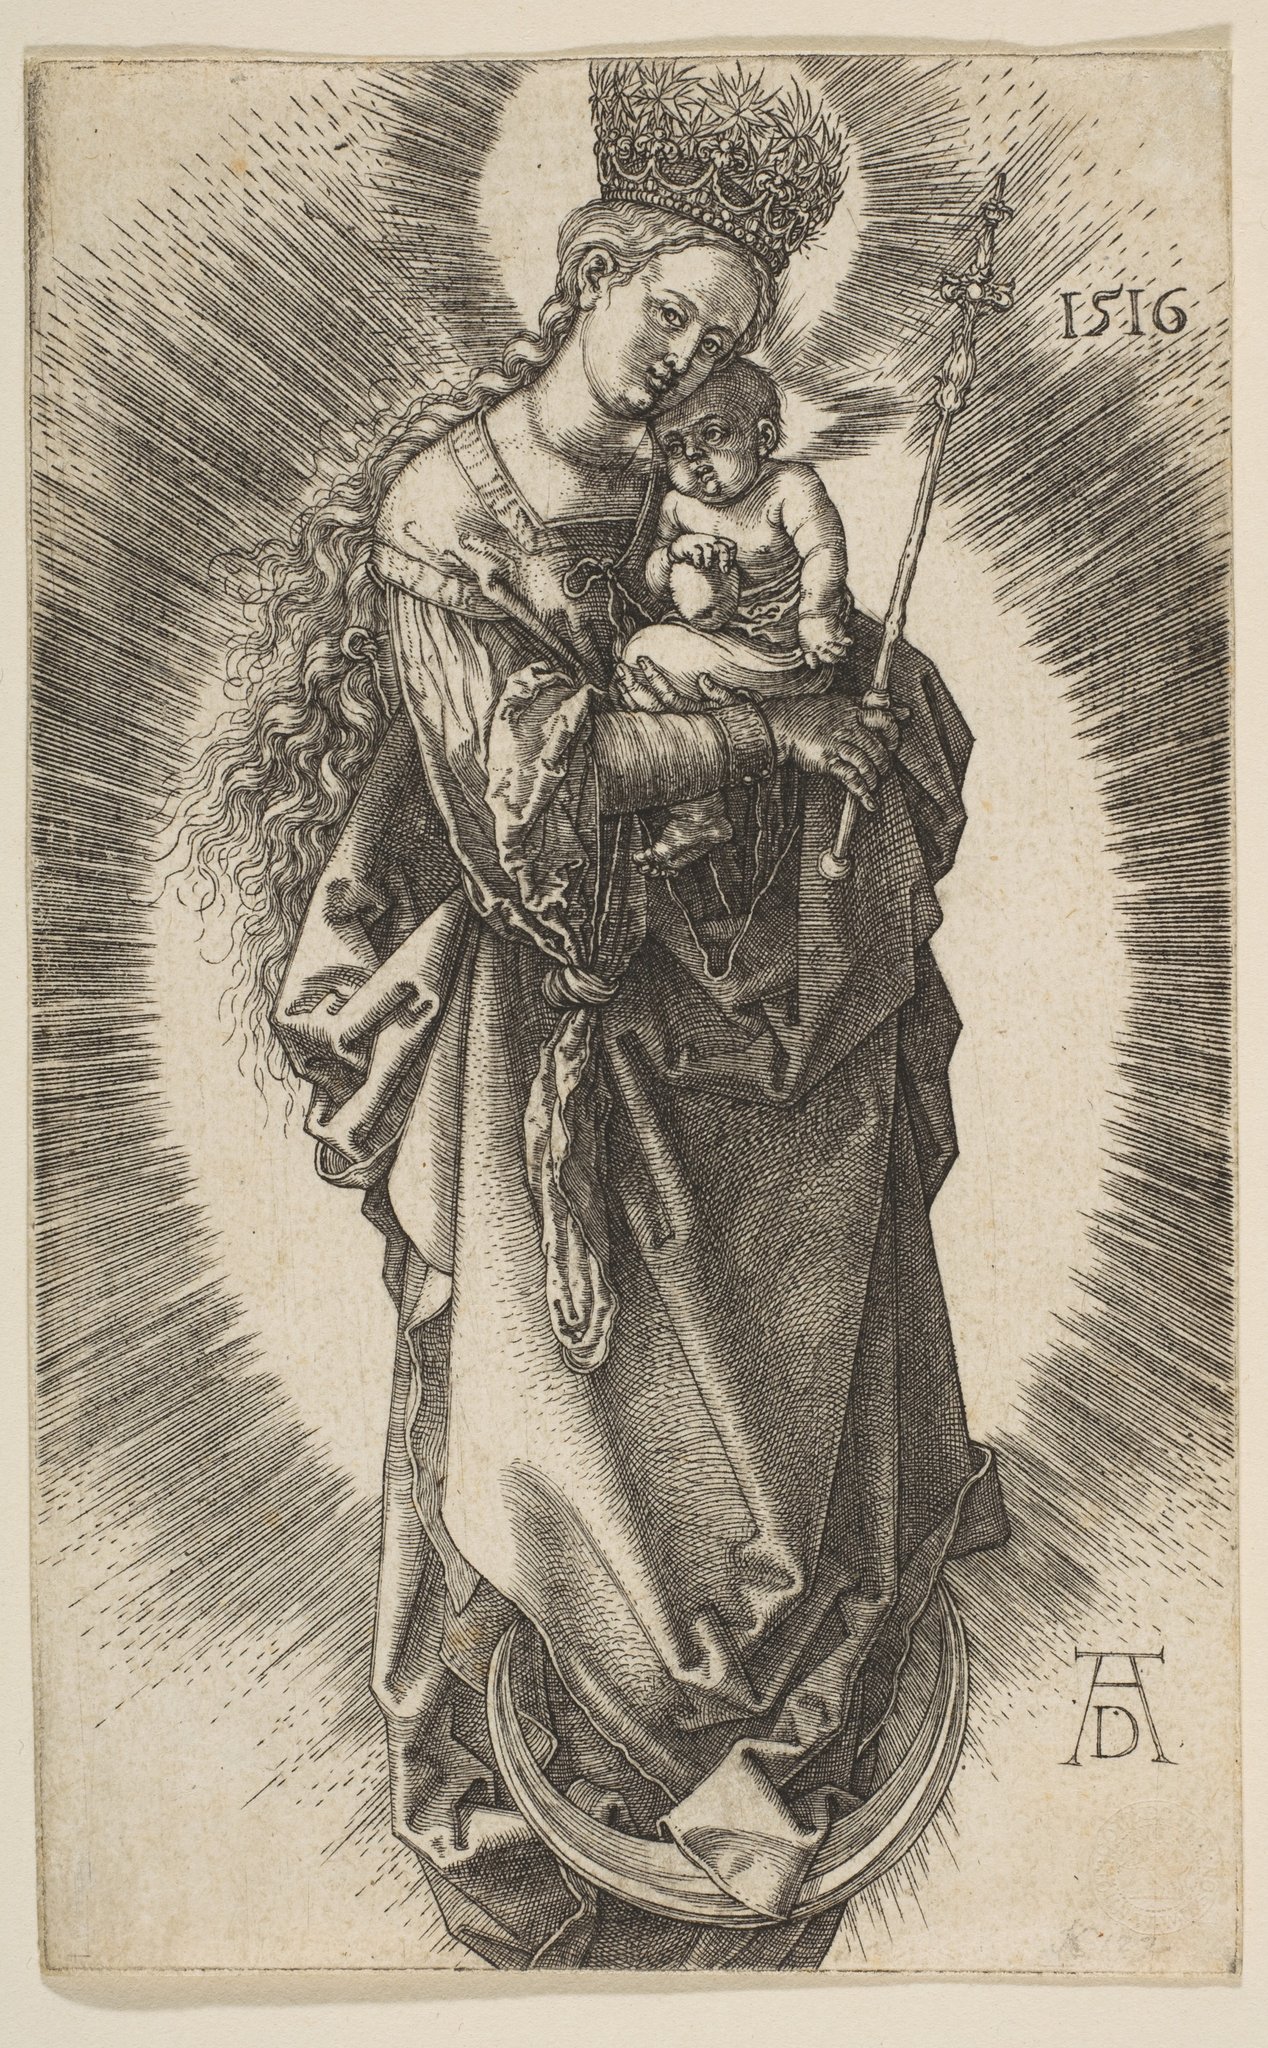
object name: print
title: Virgin on the Crescent with Scepter and Starry Crown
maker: albrecht dürer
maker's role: artist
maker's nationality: german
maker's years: 1471-1528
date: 1516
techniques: engraving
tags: madonna and child